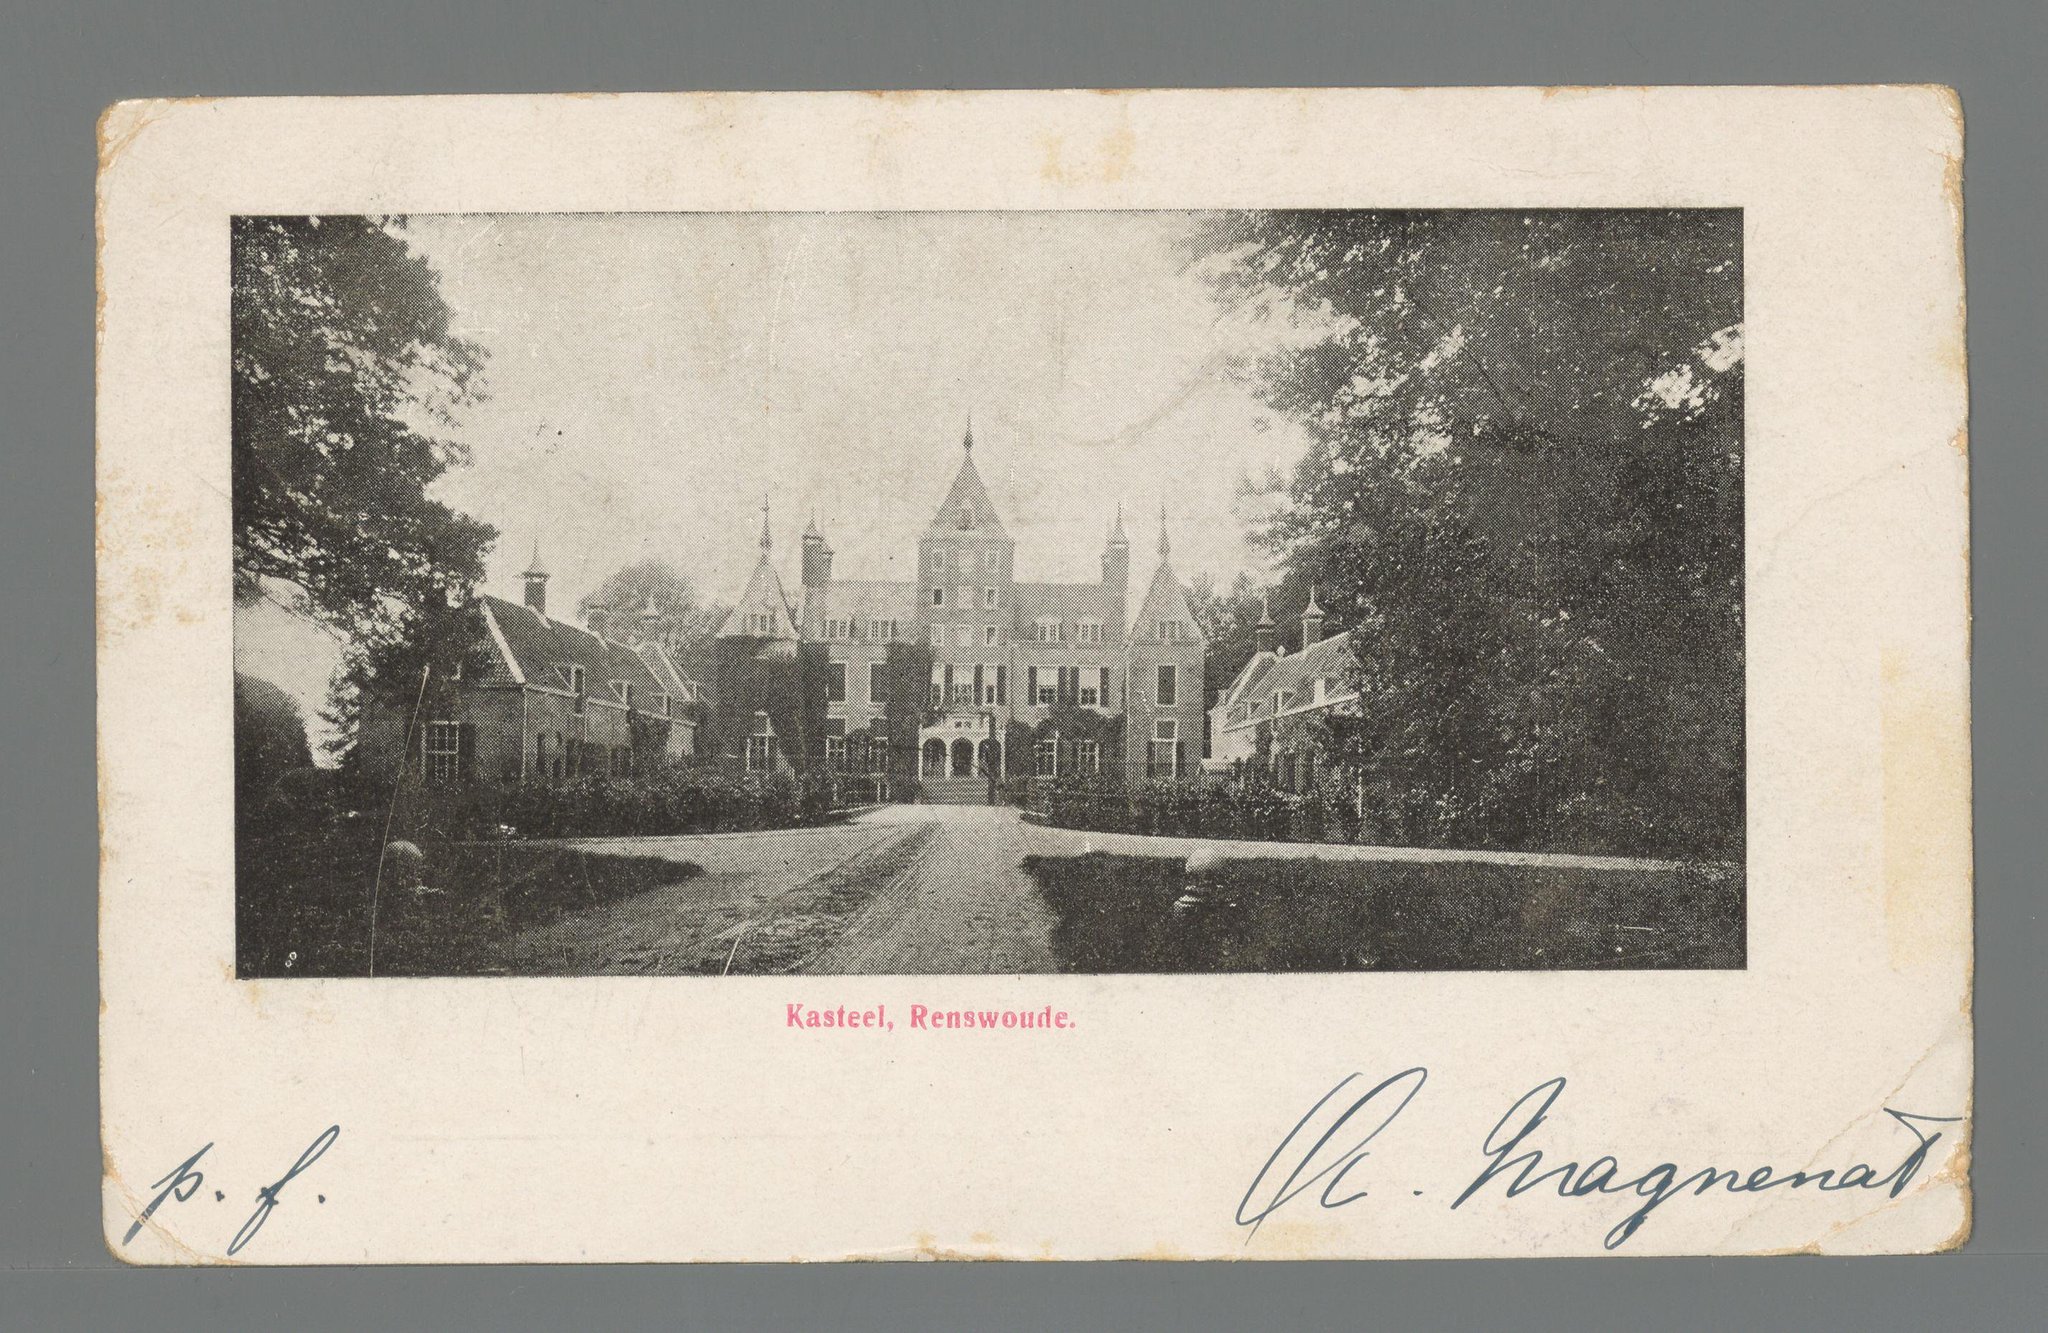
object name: photomechanical print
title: Kasteel, Renswoude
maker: Anonymous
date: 1892-1905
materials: cardboard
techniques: writing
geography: renswoude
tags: castle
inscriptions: postage stamp